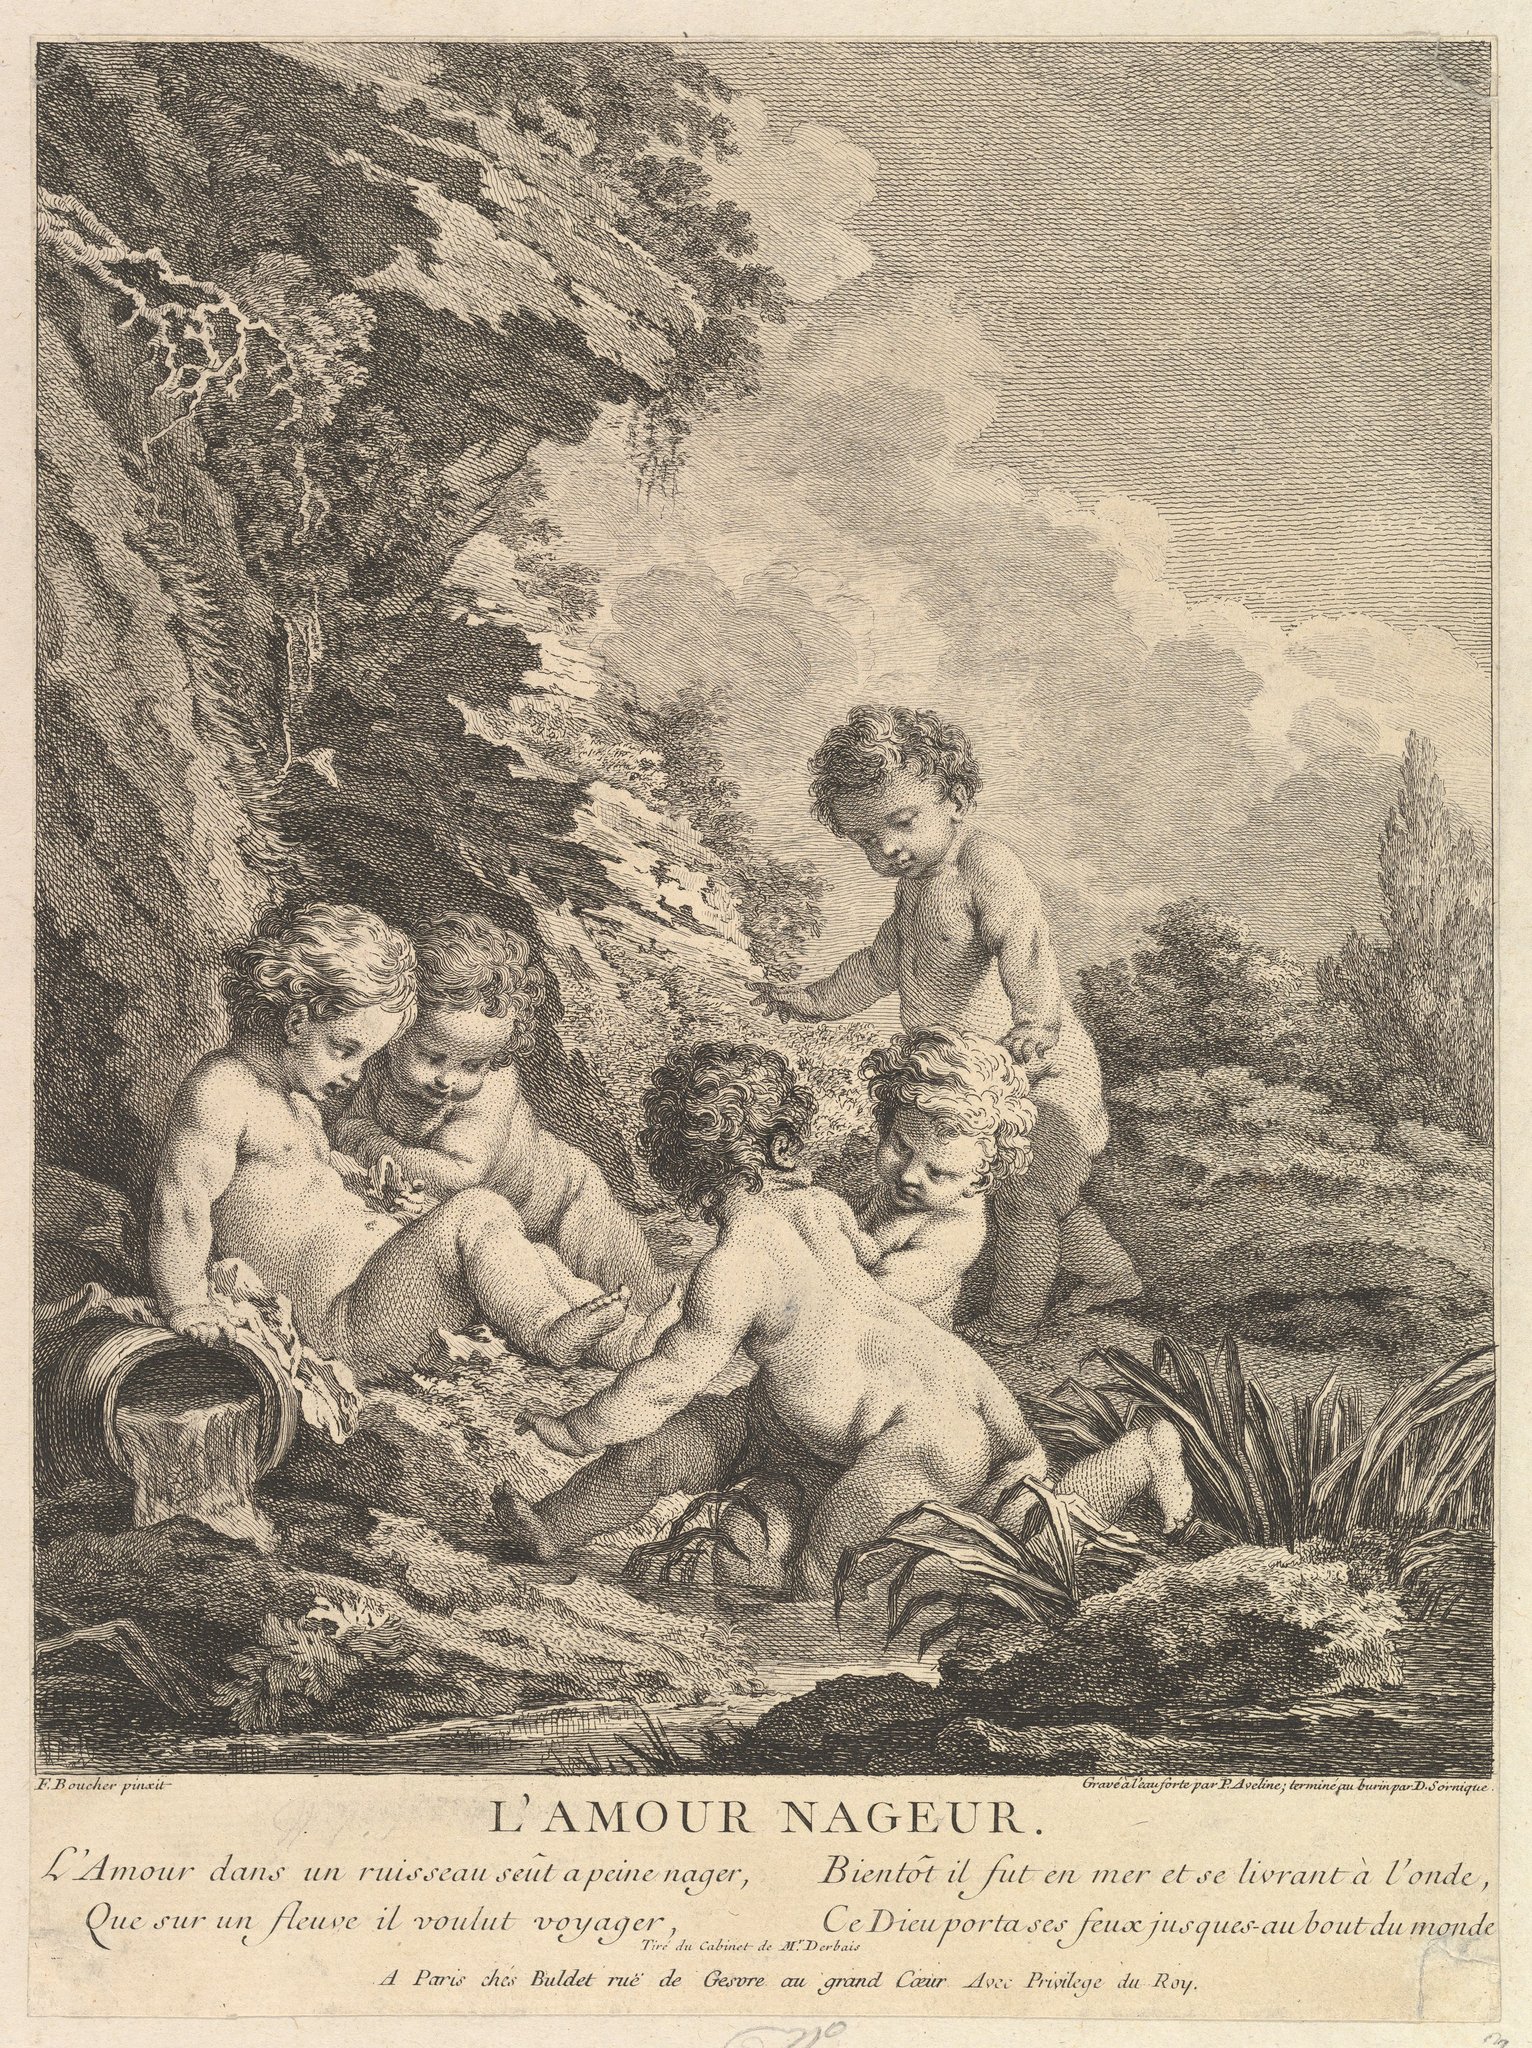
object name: print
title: The Swimming putto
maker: dominique sornique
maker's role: artist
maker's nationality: french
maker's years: 1708-1756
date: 1741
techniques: engraving, etching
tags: children,swimming